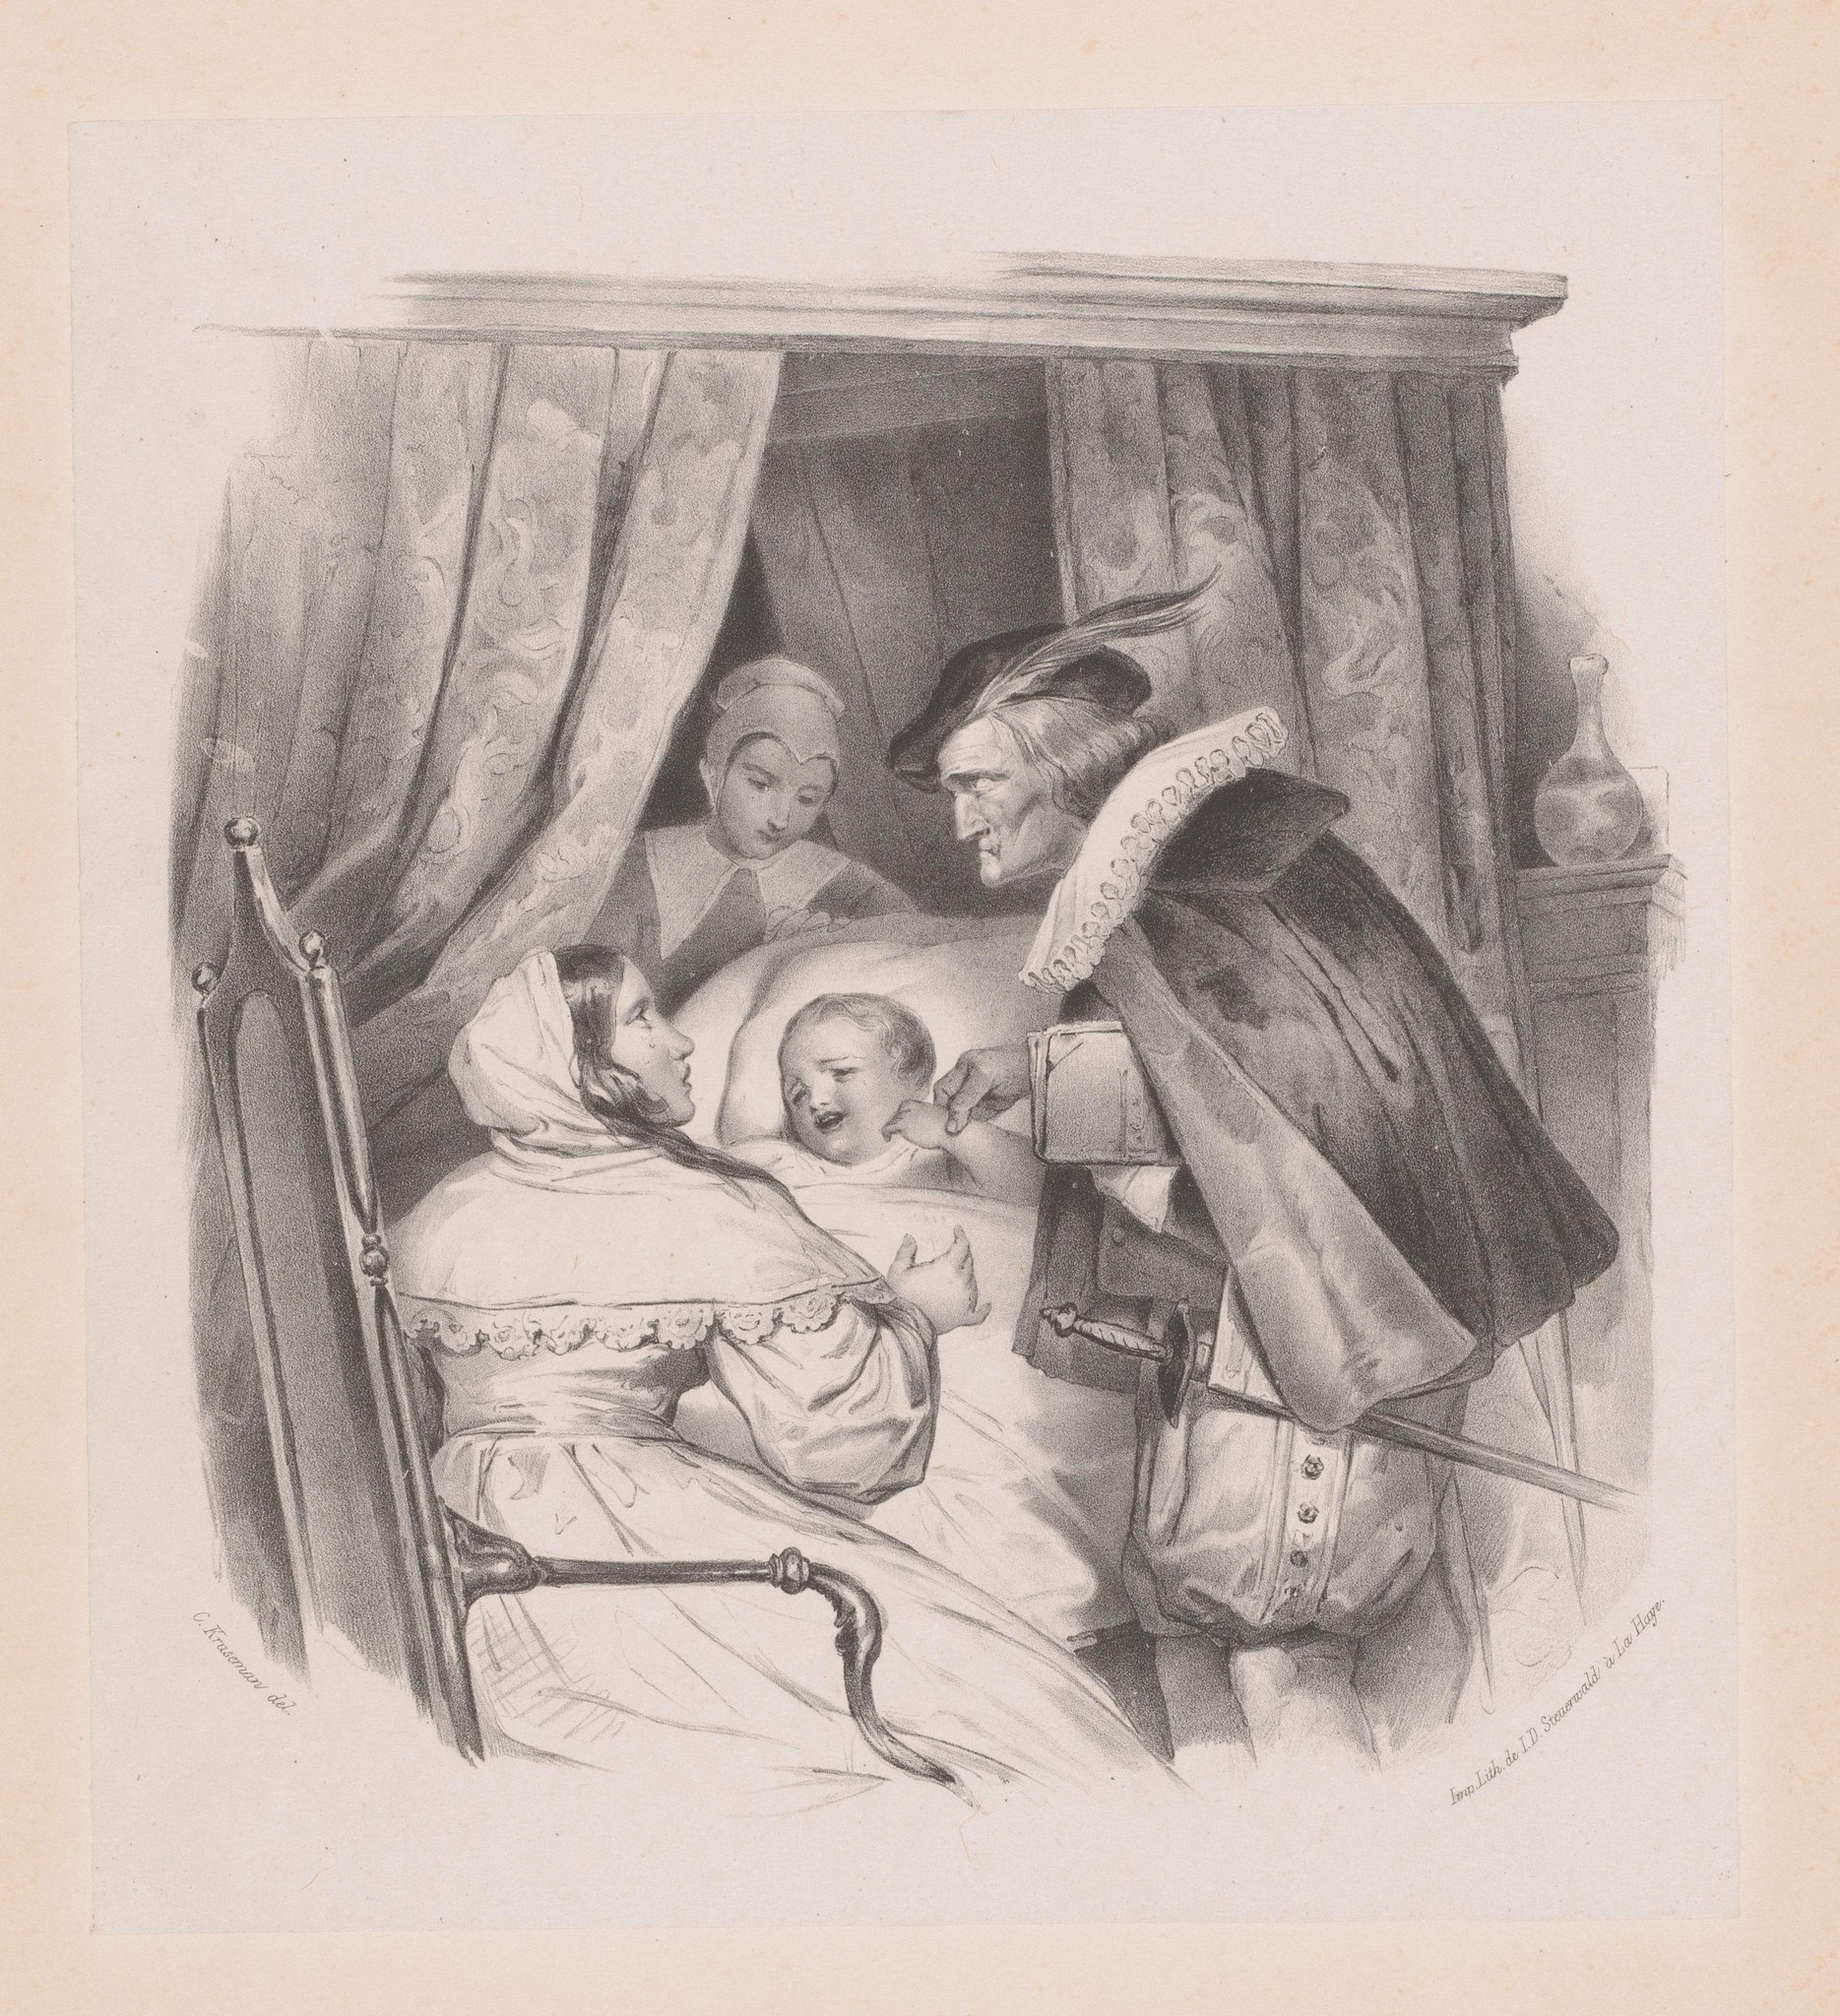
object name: print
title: Gezelschap bij een ziek kind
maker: jan dam steuerwald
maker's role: print maker, printer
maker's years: 1805-1869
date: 1833-1863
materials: paper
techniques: lithograph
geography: the hague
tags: sick-bed, physician, doctor, mother and baby or young child, visiting the sick; sick person together with others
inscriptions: collector's mark: Lugt 2228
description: Het kind ligt huilend in bed, de moeder zit ernaast in een stoel. Een dokter, knijpt in de arm van het kind. Achter het bed staat een meisje.